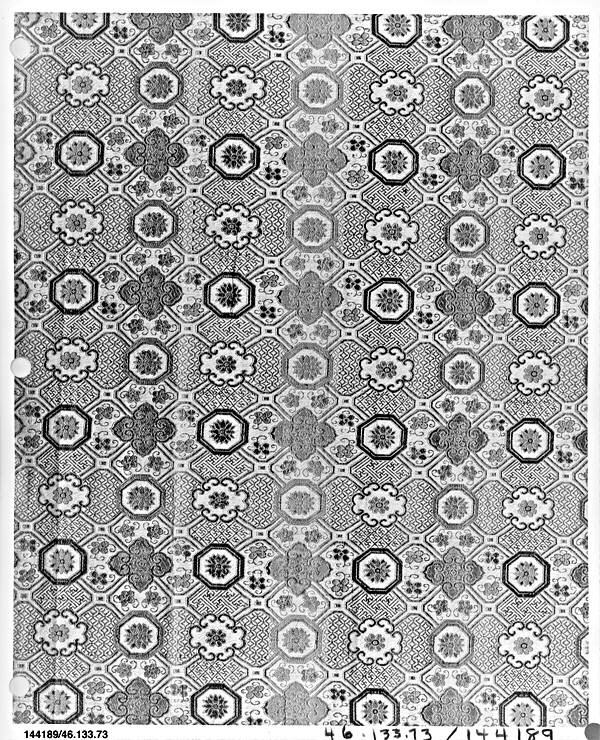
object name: piece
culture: chinese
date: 1801-1900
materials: silk